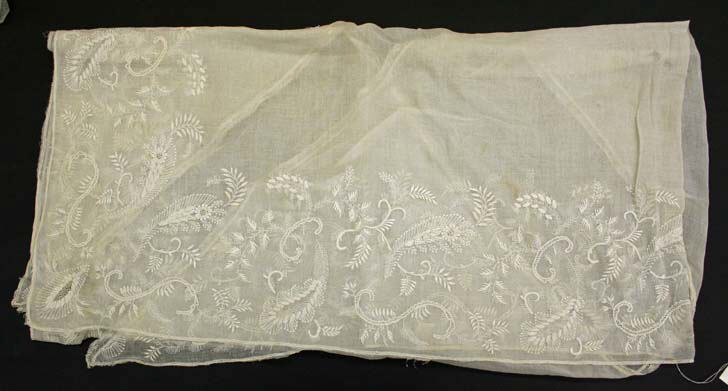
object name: shawl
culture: british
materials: cotton